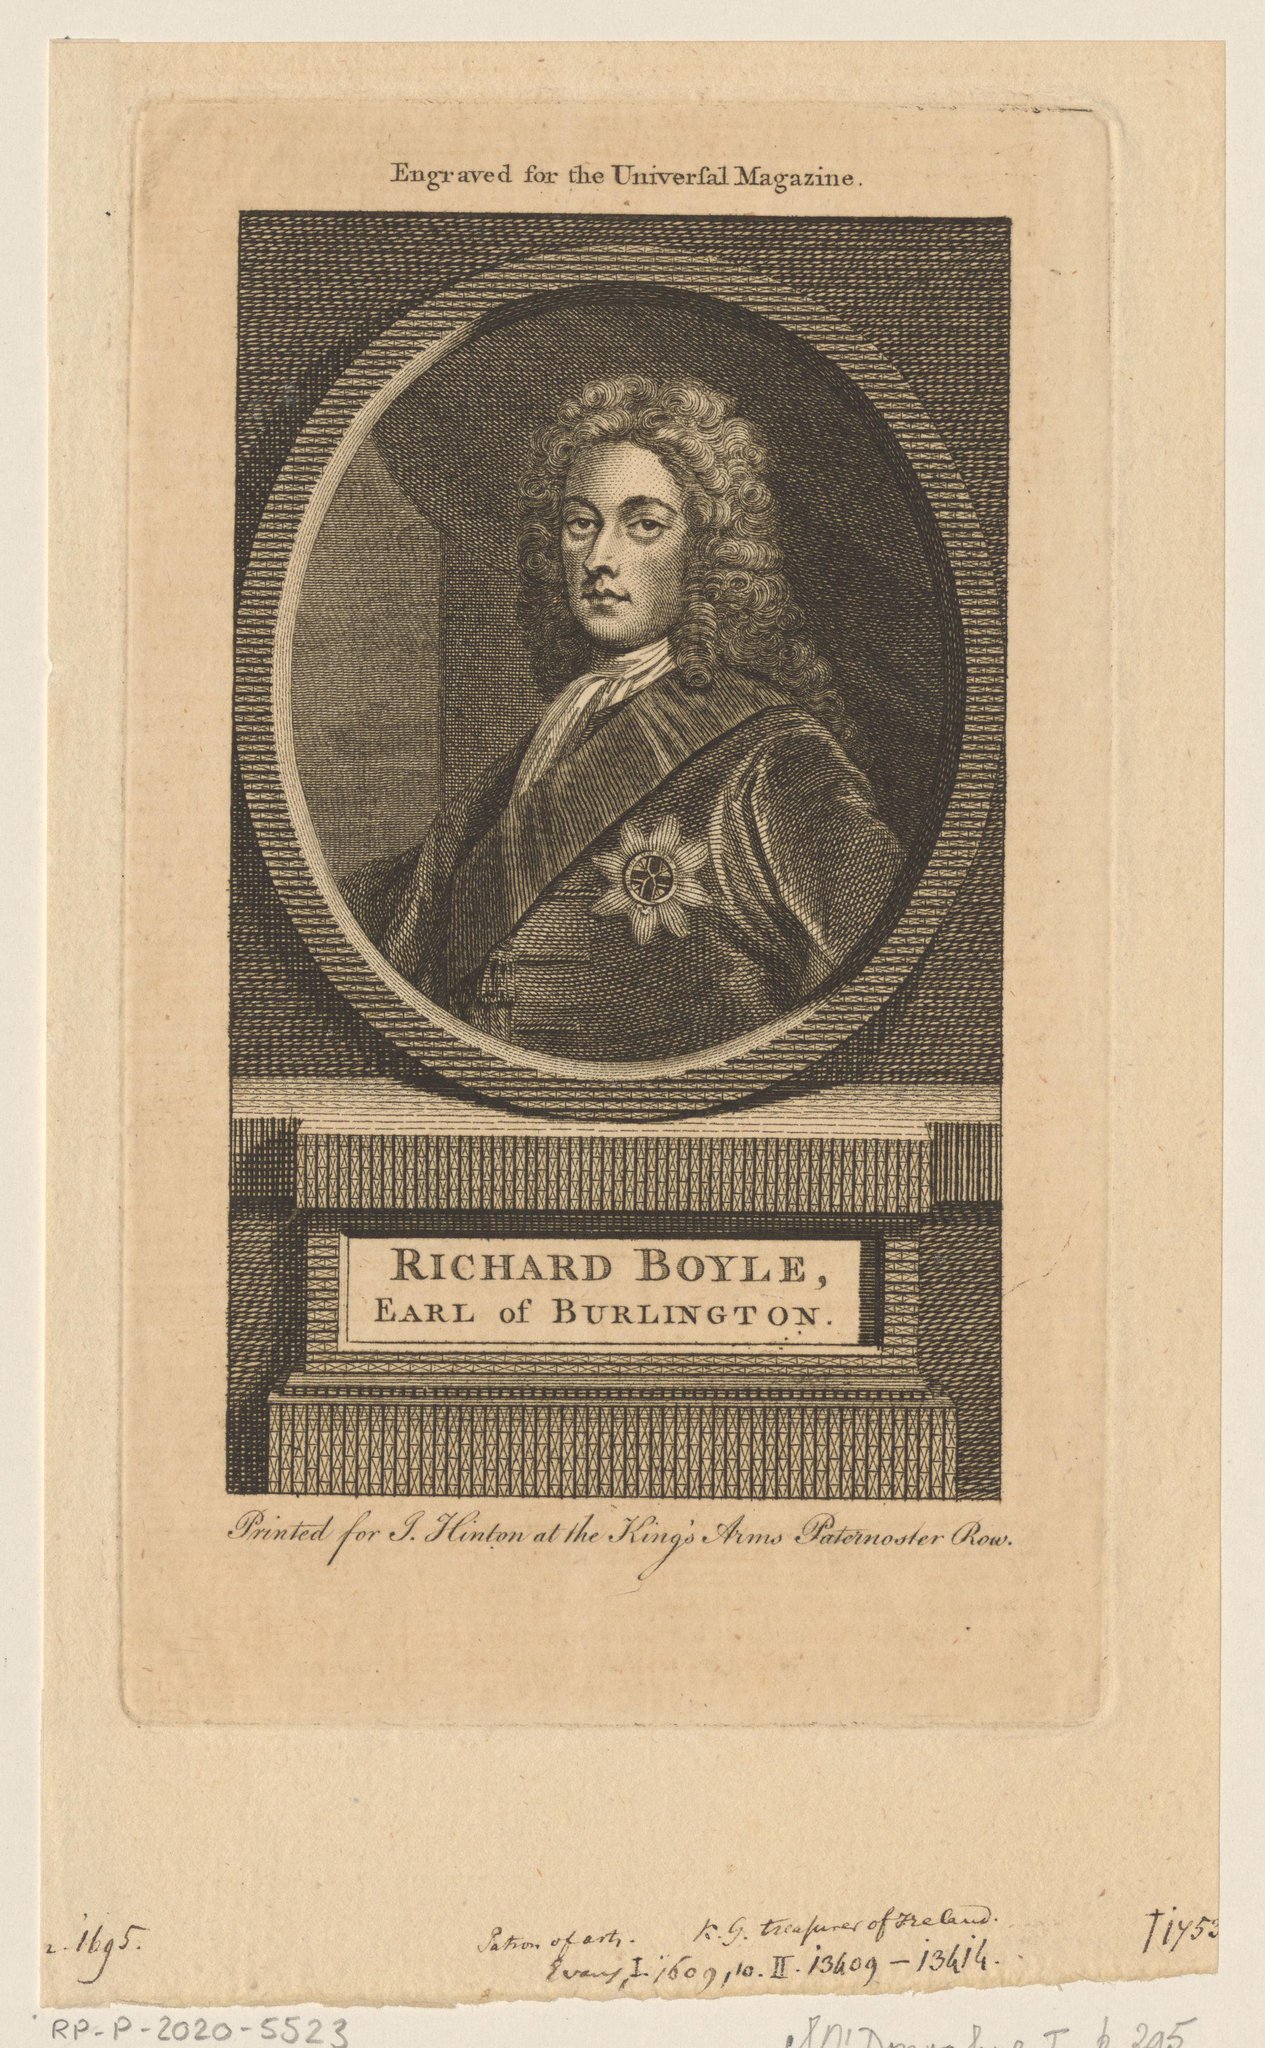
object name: print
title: Portret van Richard Boyle, graaf van Burlington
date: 1747-1781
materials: paper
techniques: engraving, etching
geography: london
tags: politician, richard boyle (3e graaf van burlington), historical persons, politician, e.g. party leader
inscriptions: inscription: ‘n. 1695 [...] K.G. Treasurer of Ireland./ Evary, I 1609, 10 II 13409-13414. +1753’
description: Prent uit: The Universal Magazine of Knowledge and Pleasure, 1747-1781.